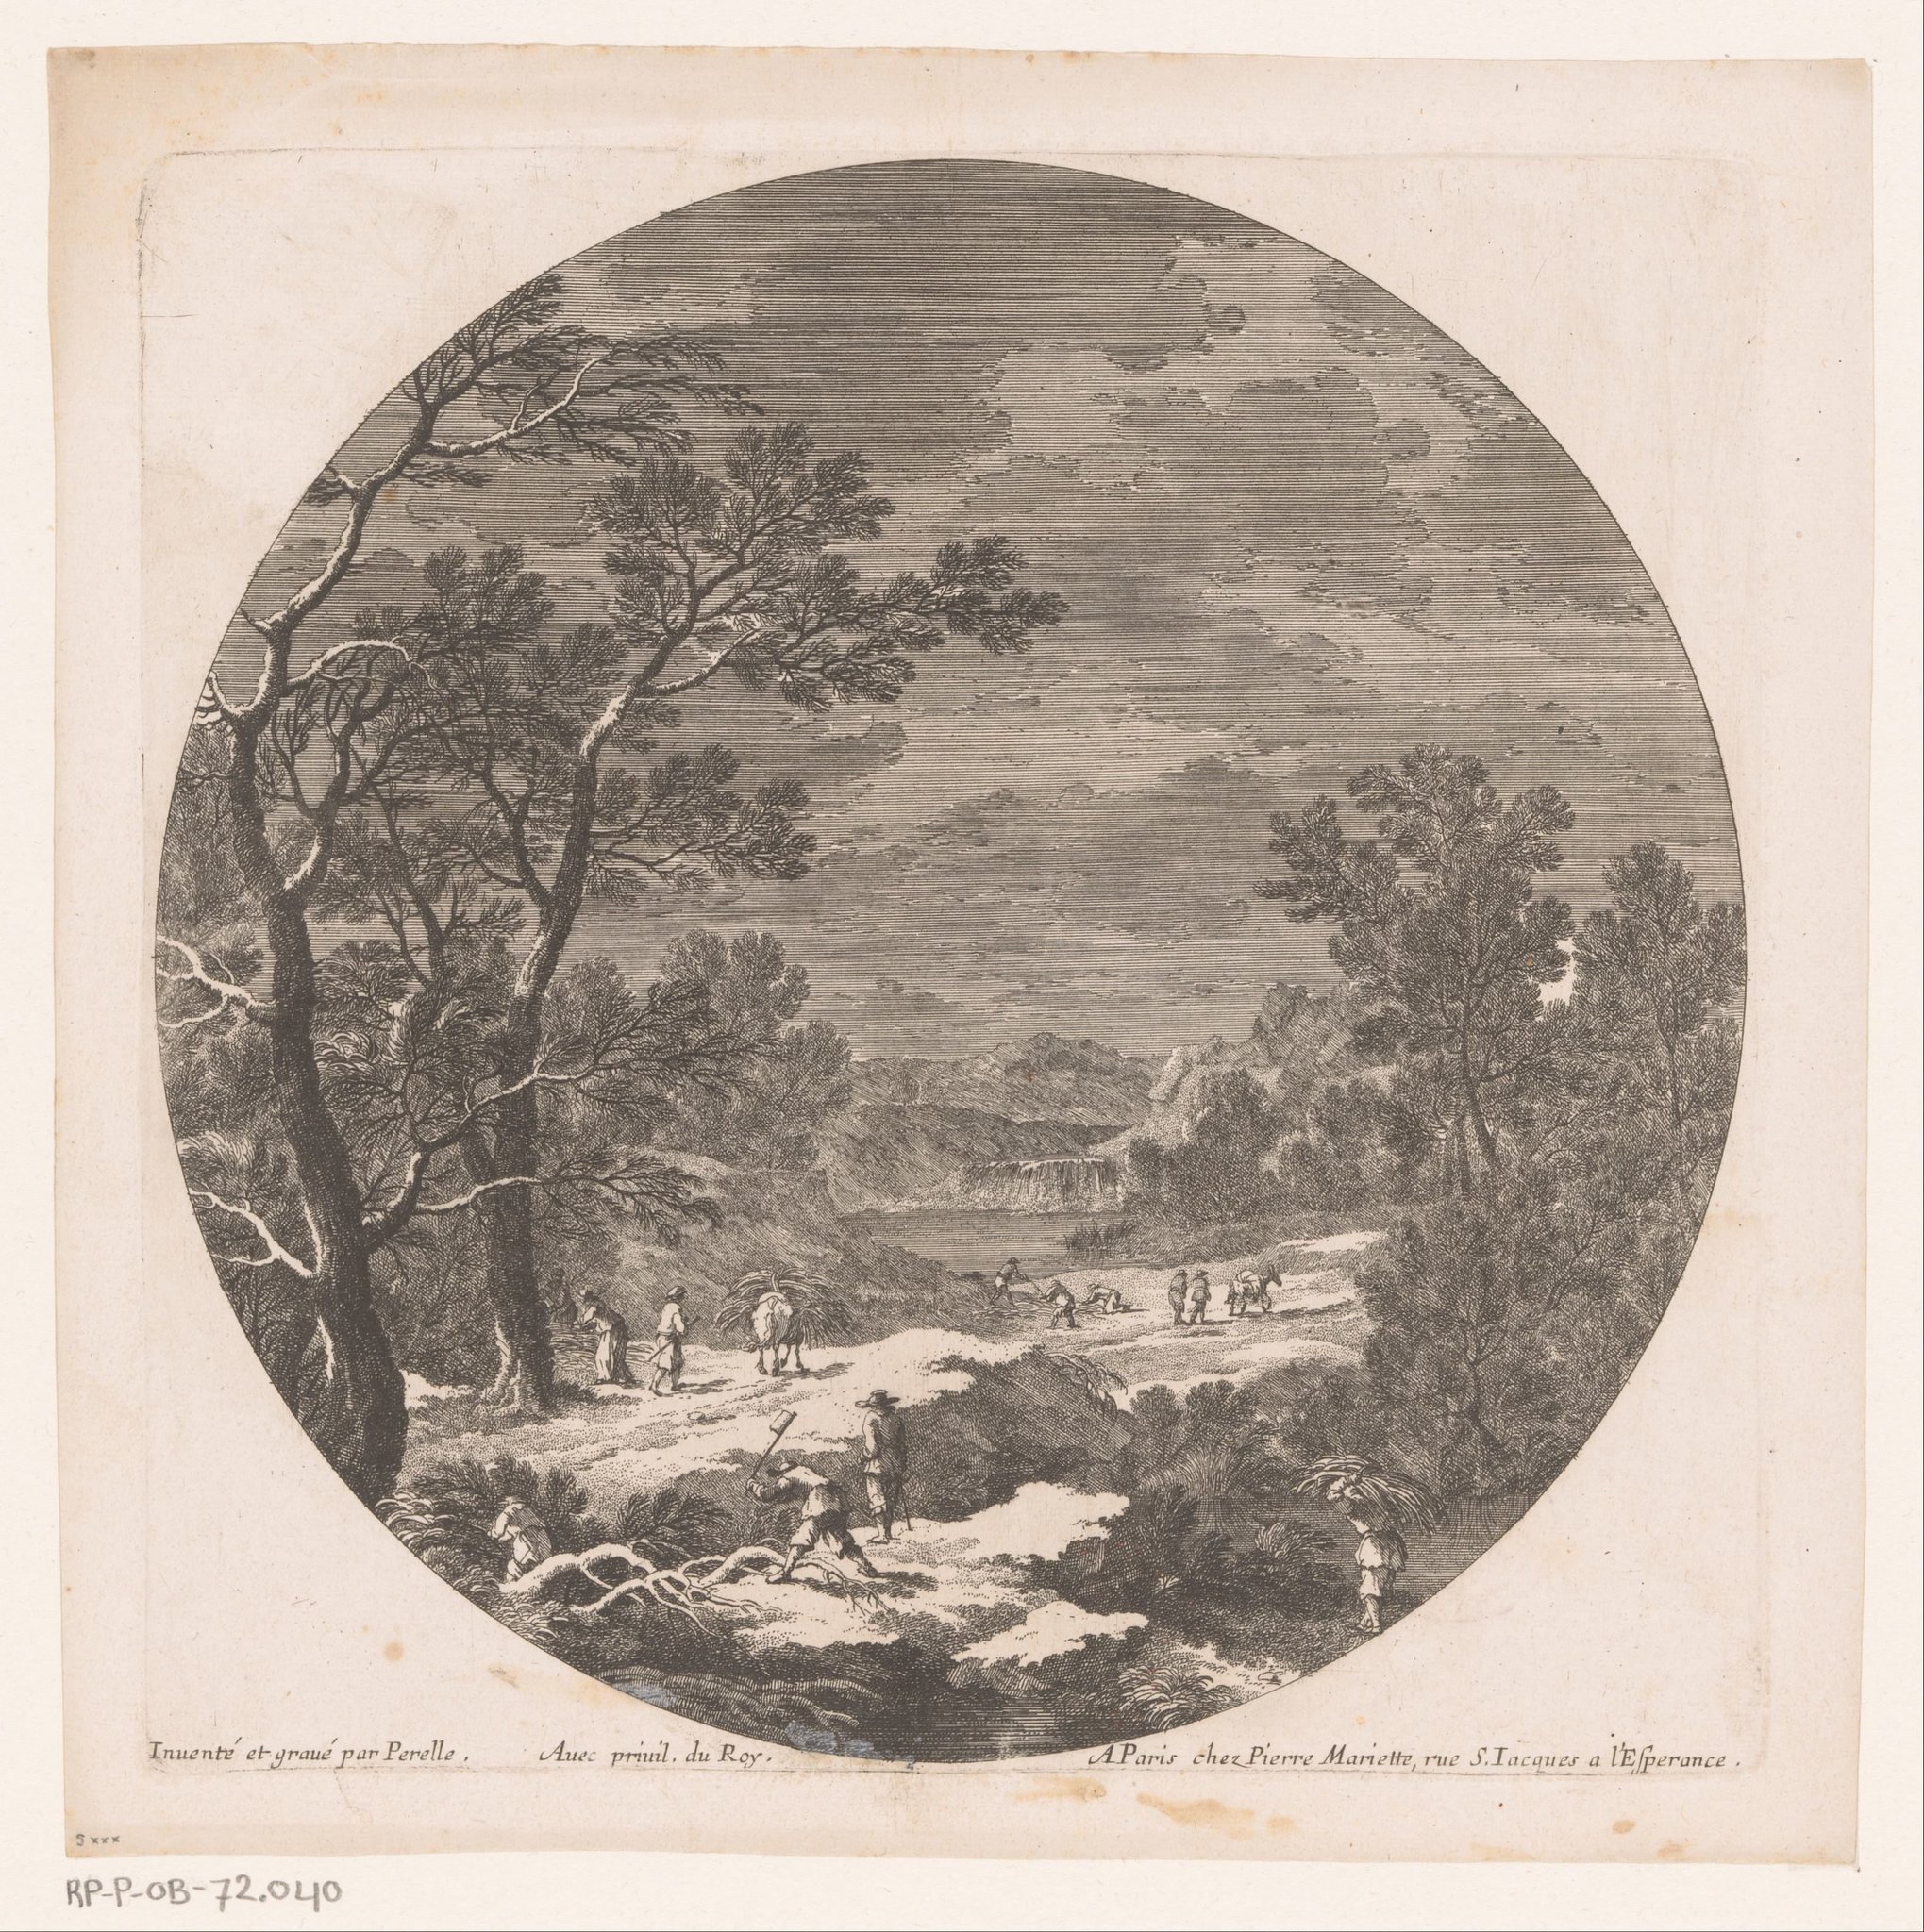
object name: print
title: Landschap met bosarbeiders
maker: pierre mariette (i)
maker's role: print maker, publisher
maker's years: 1596-1657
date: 1613-1657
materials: paper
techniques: engraving, etching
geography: france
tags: woodcutting, woodcutter ~ forestry, forest, wood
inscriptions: collector's mark: Lugt 240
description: Prenten met het signatuur 'Perelle' kunnen zowel door vader Gabriel als door zonen Nicolas en Adam gemaakt zijn.